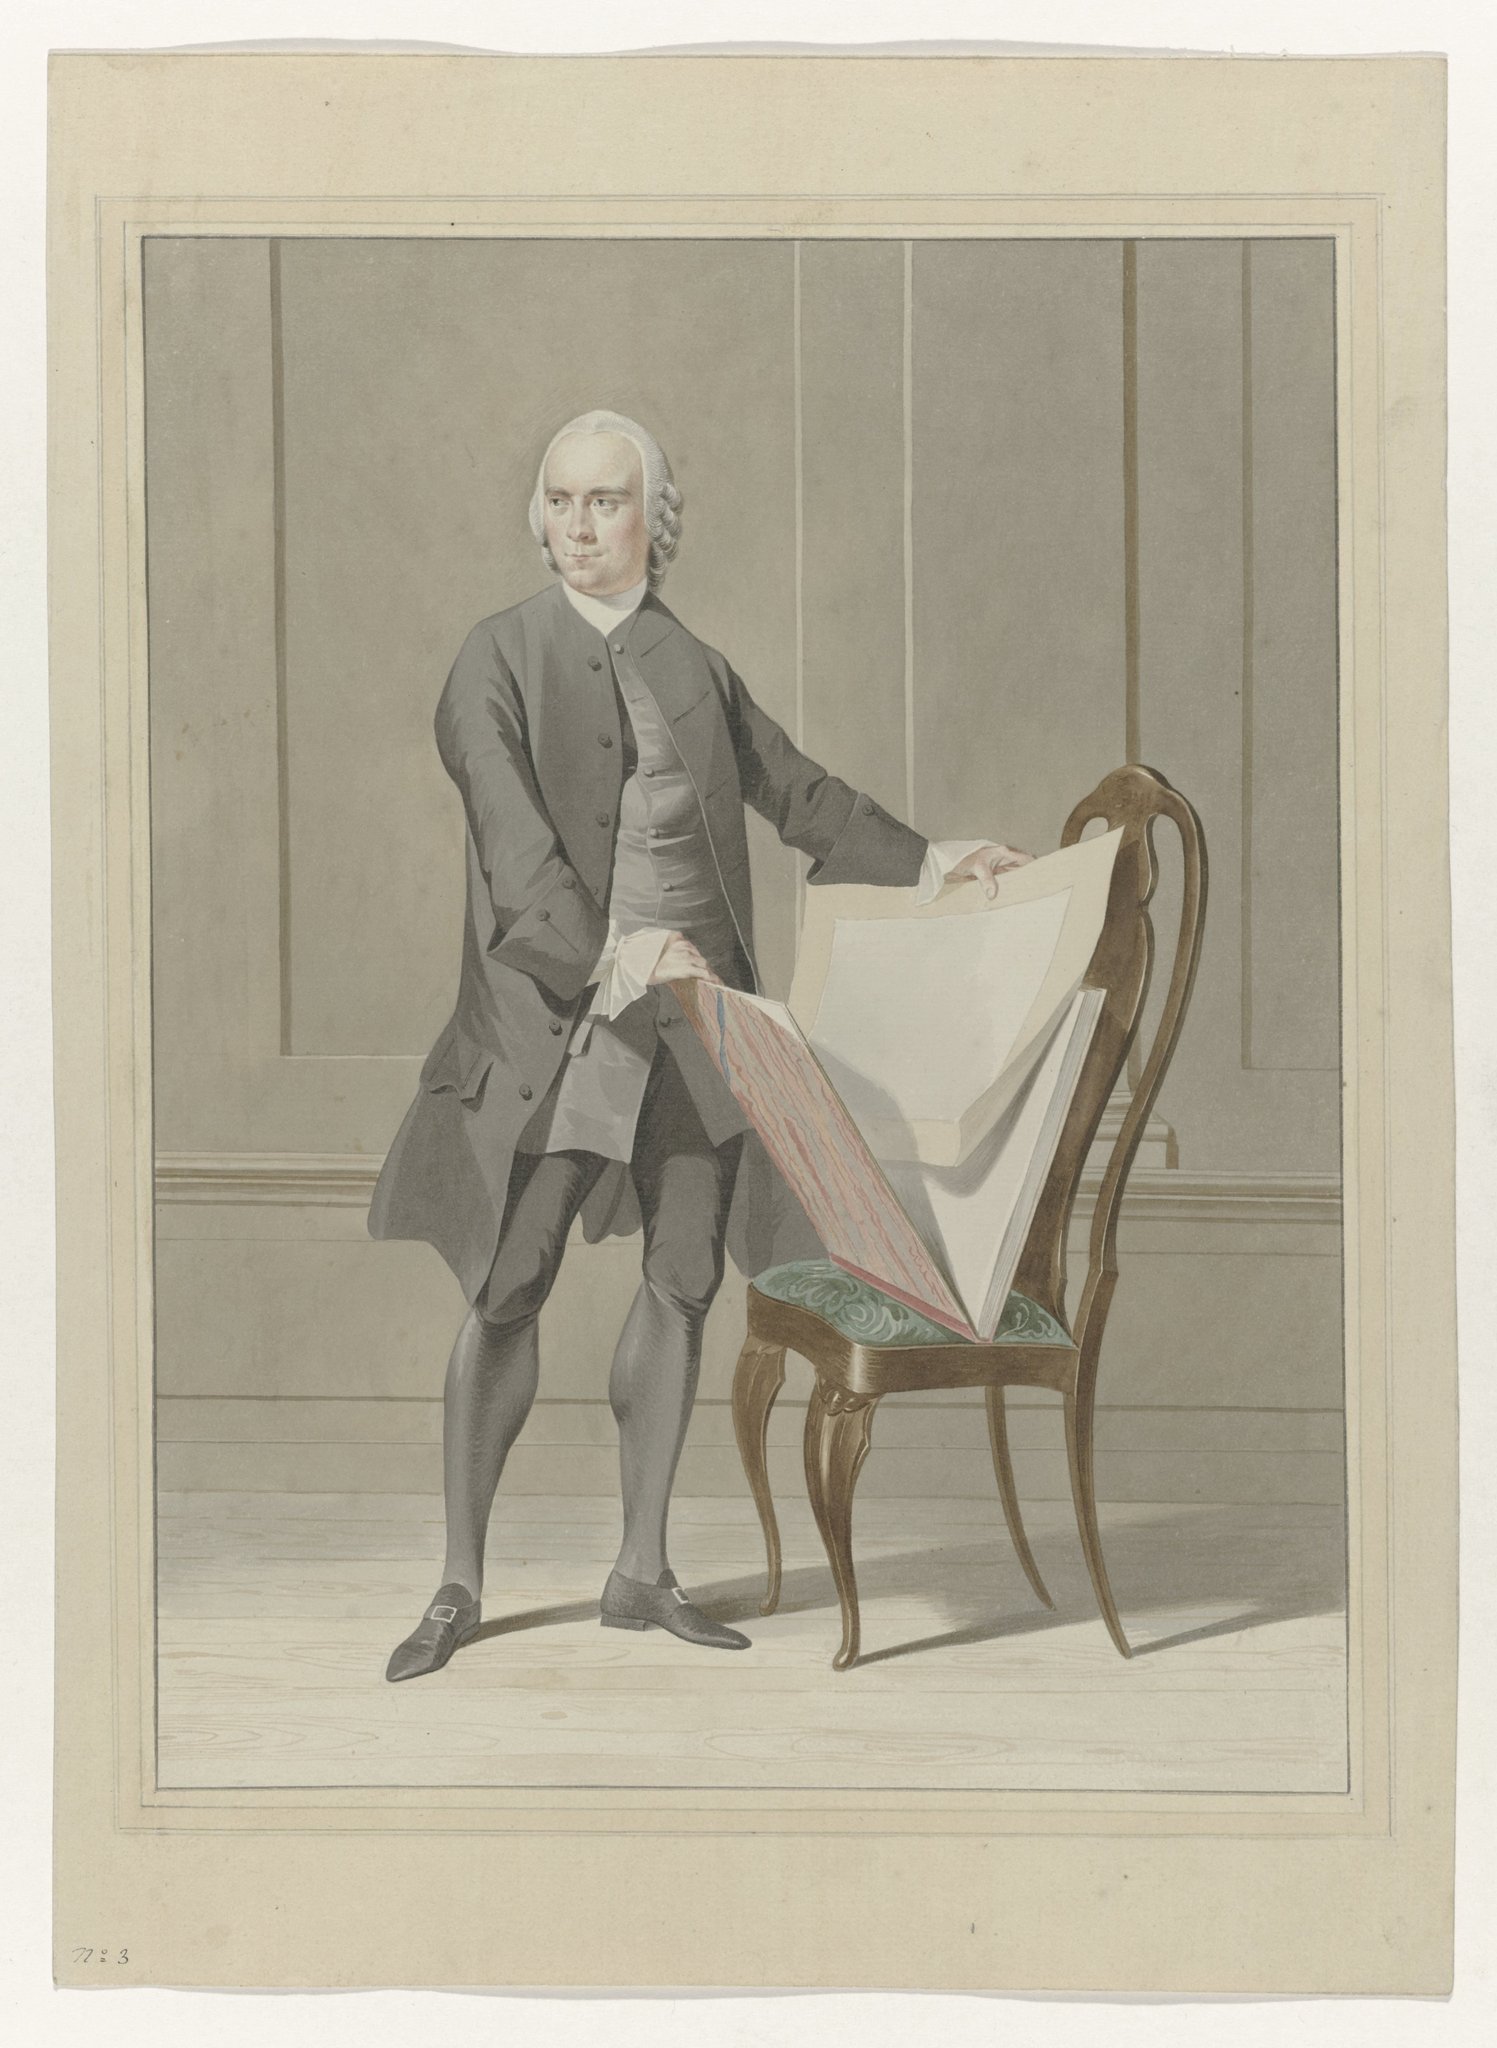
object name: drawing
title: Cornelis Ploos van Amstel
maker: Anonymous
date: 1756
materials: paint, paper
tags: amsterdam, print maker, draughtsman, cornelis ploos van amstel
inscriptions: number: ‘No 3’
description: Tekening uit familieboek Ploos van Amstel, begonnen door Cornelis Ploos van Amstel.